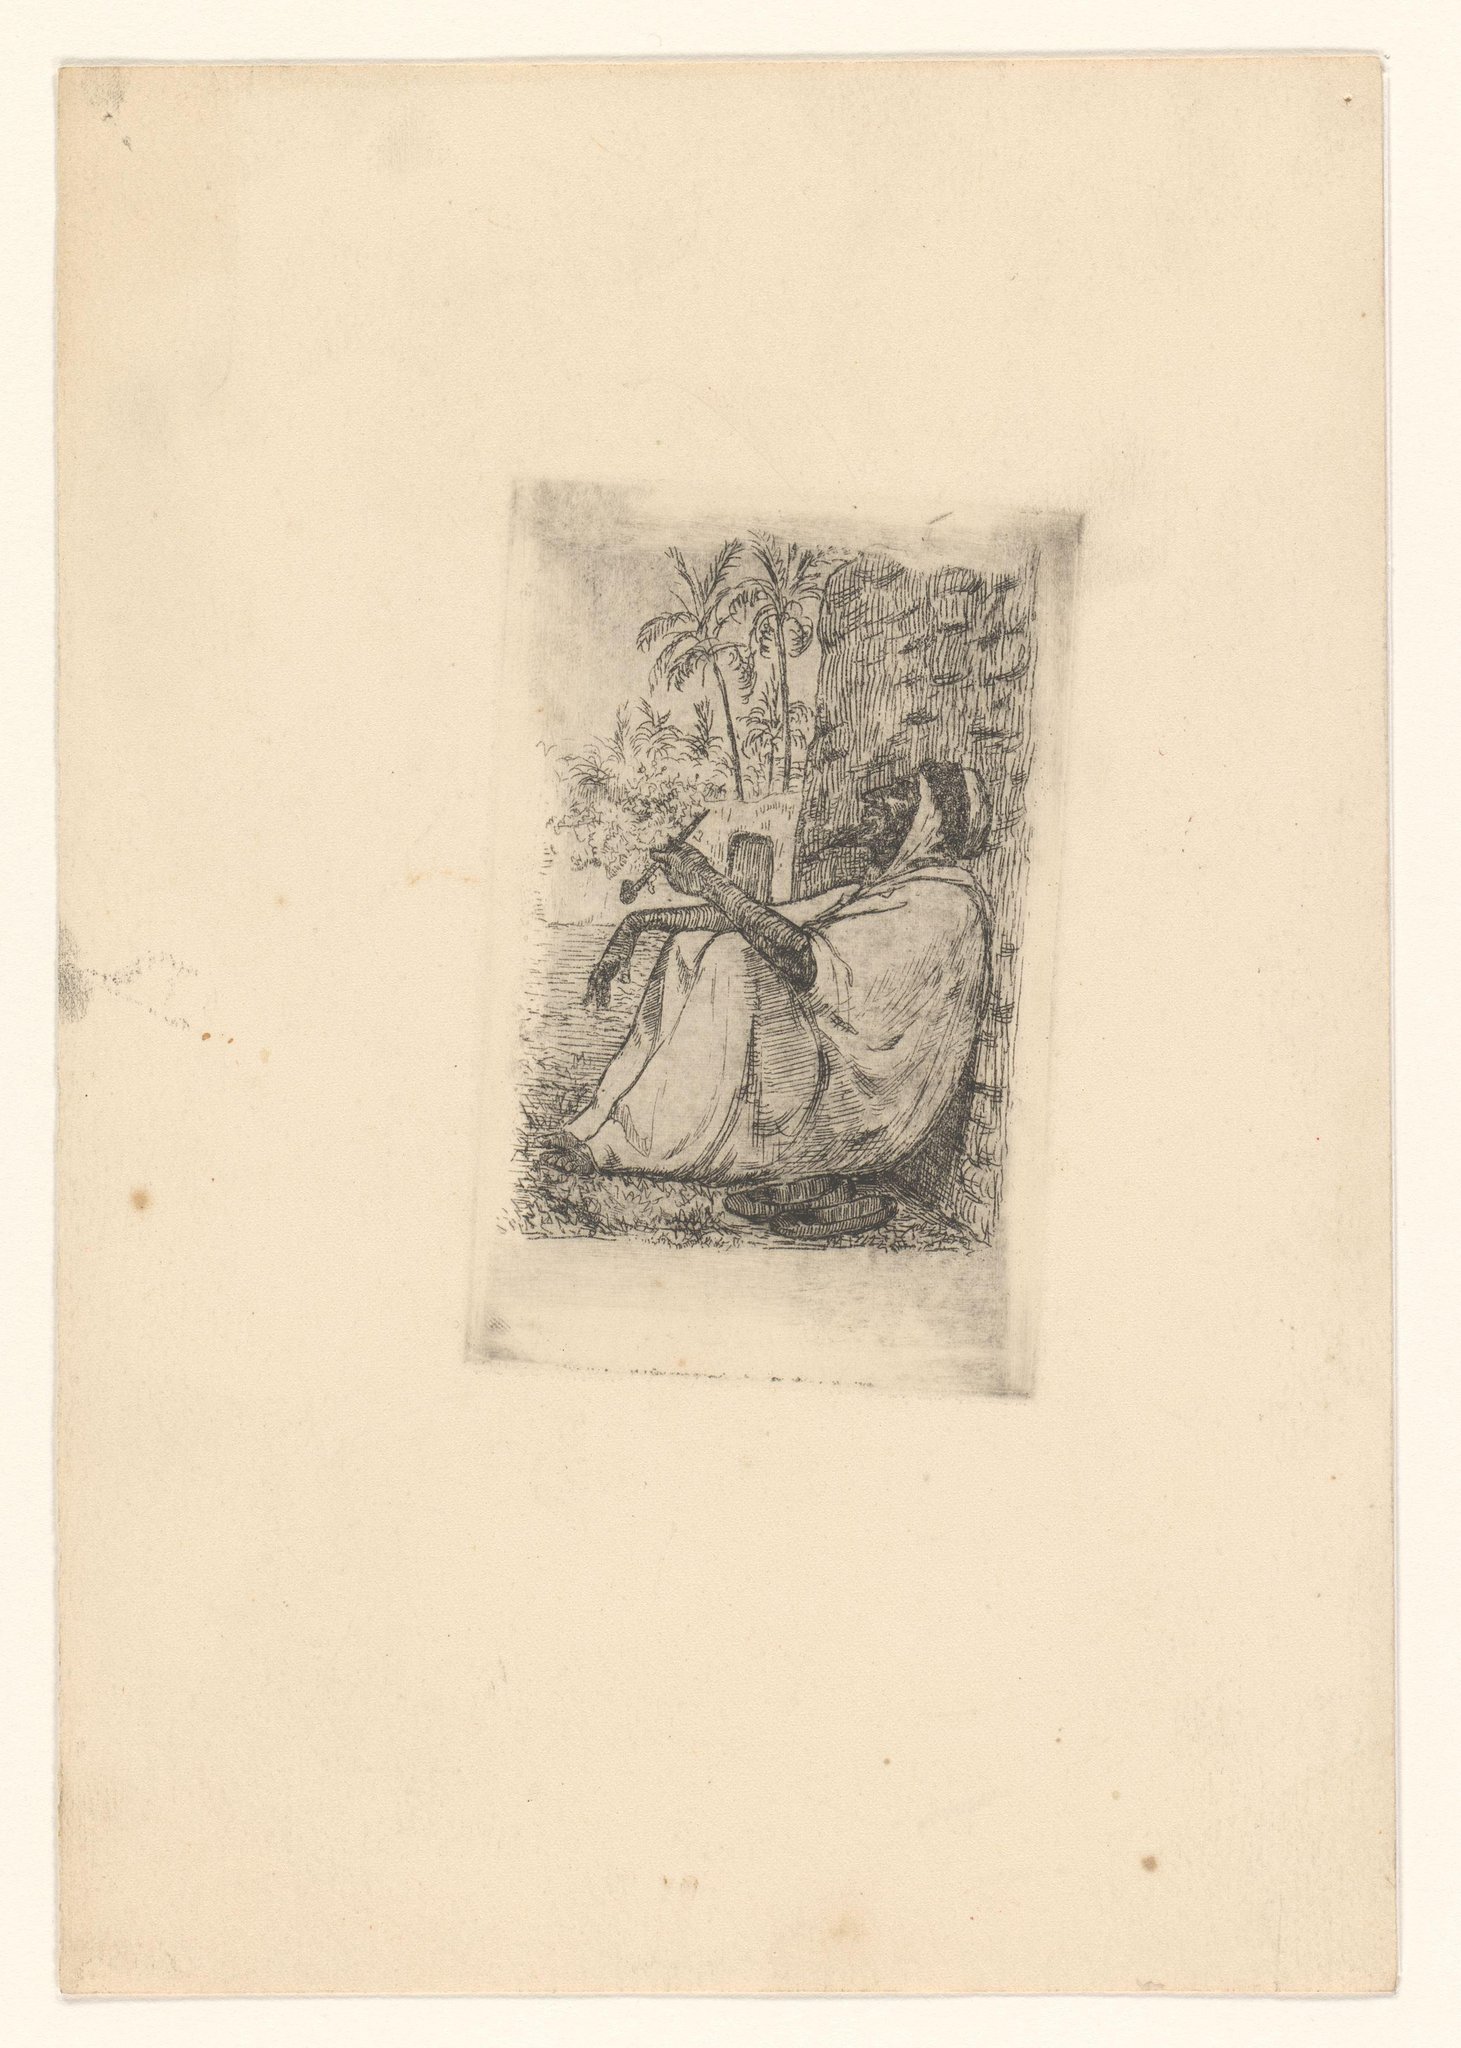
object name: print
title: Pijprokende man zittend tegen een muur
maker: Anonymous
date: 1860-1920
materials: paper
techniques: etching, intaglio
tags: pipe ~ tobacco (+ taking (particular) foodstuffs: eating, drinking, smoking, chewing, etc.)